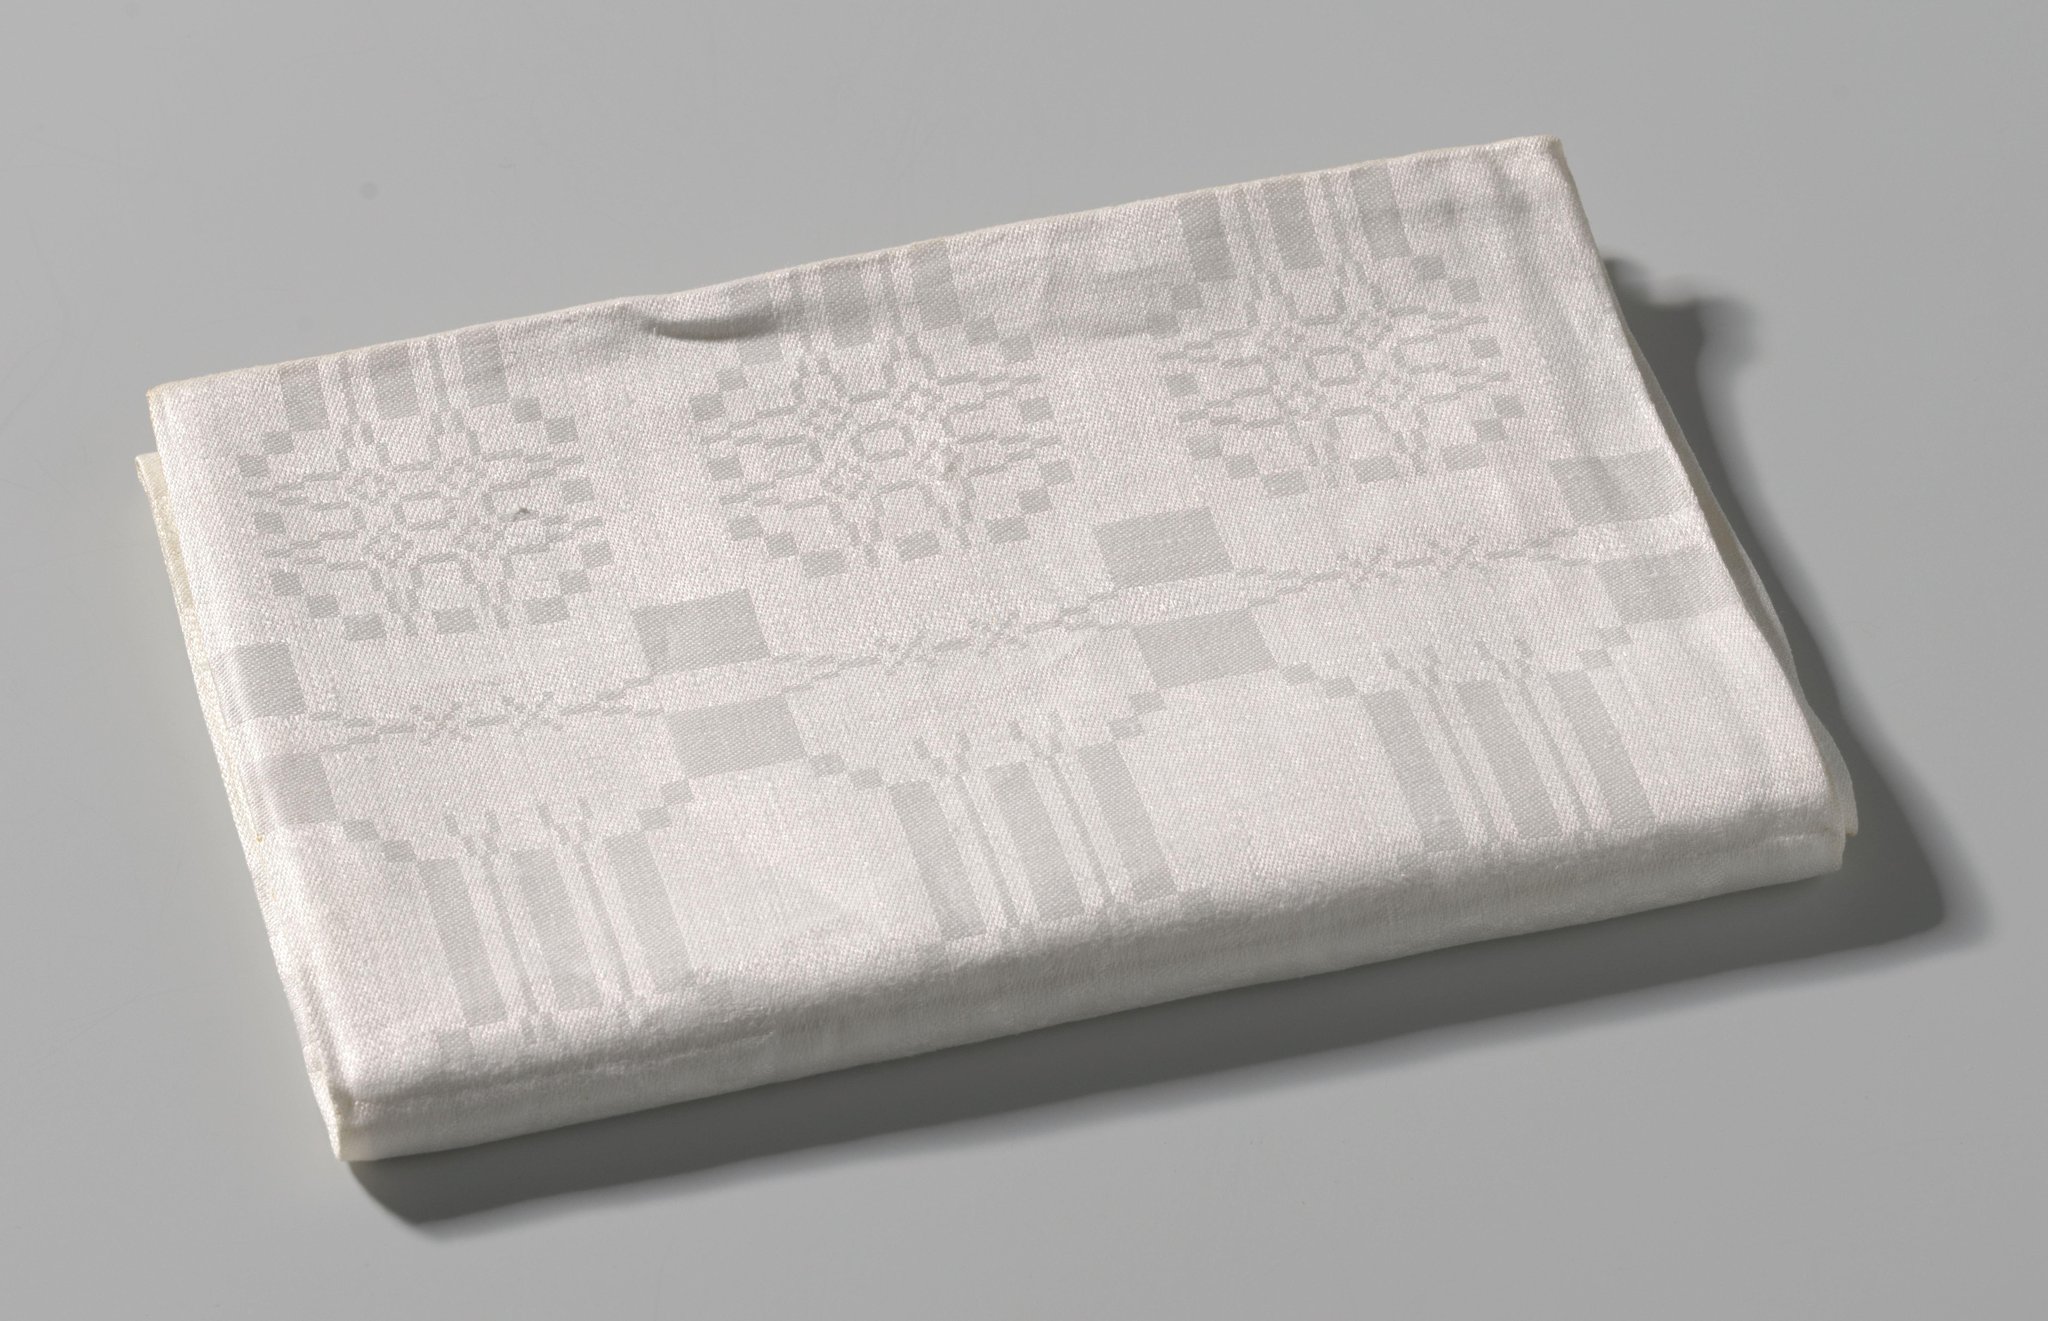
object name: napkin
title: Servet van linnen met pellenpatroon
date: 1700-1780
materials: linen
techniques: peeled fabric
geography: northern netherlands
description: wit linnen servet met pellen patroon, z.g. Oranjeboom, merk WS 24